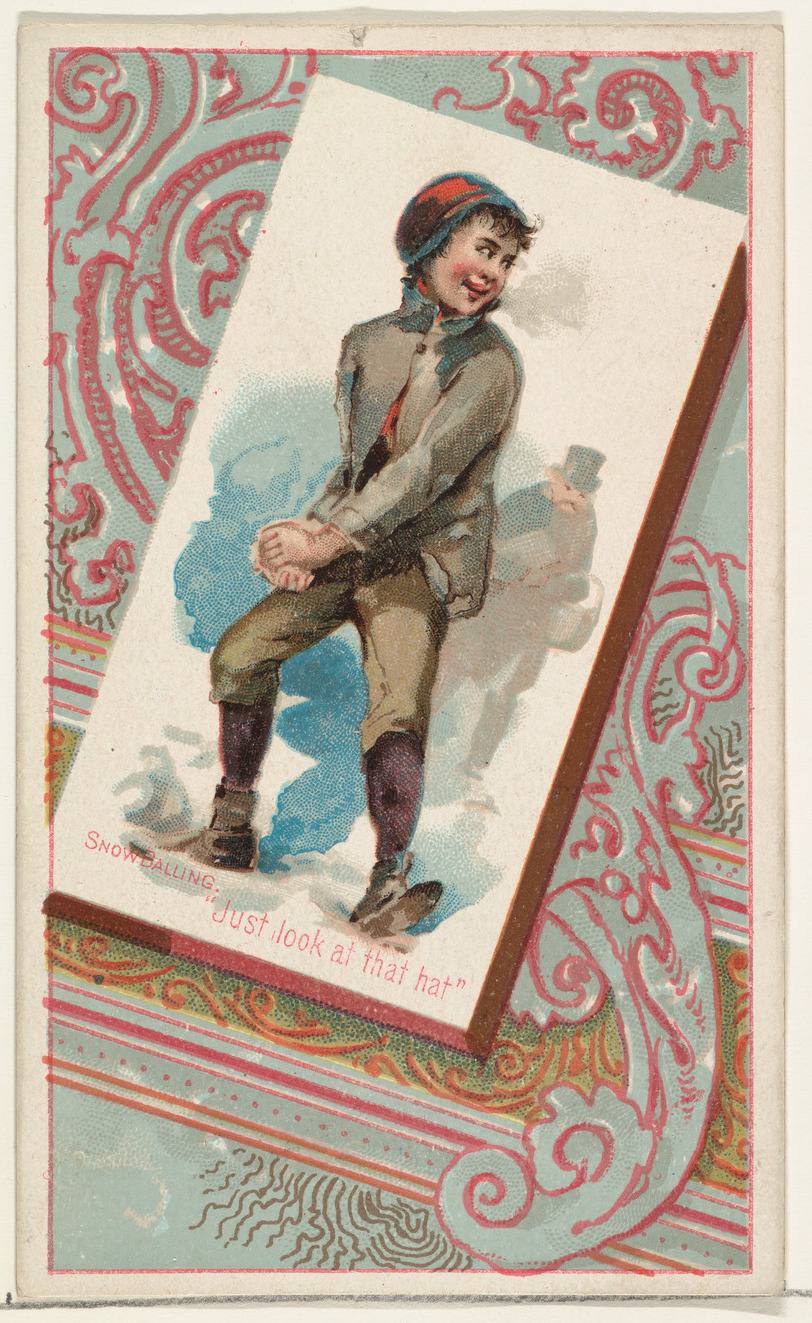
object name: print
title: Snow Balling, "Just look at that hat," from the Terrors of America set (N136) issued by Duke Sons & Co. to promote Honest Long Cut Tobacco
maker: w. duke, sons & co.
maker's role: publisher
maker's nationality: american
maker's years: 1870-1920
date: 1888-1889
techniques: color lithograph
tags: girls